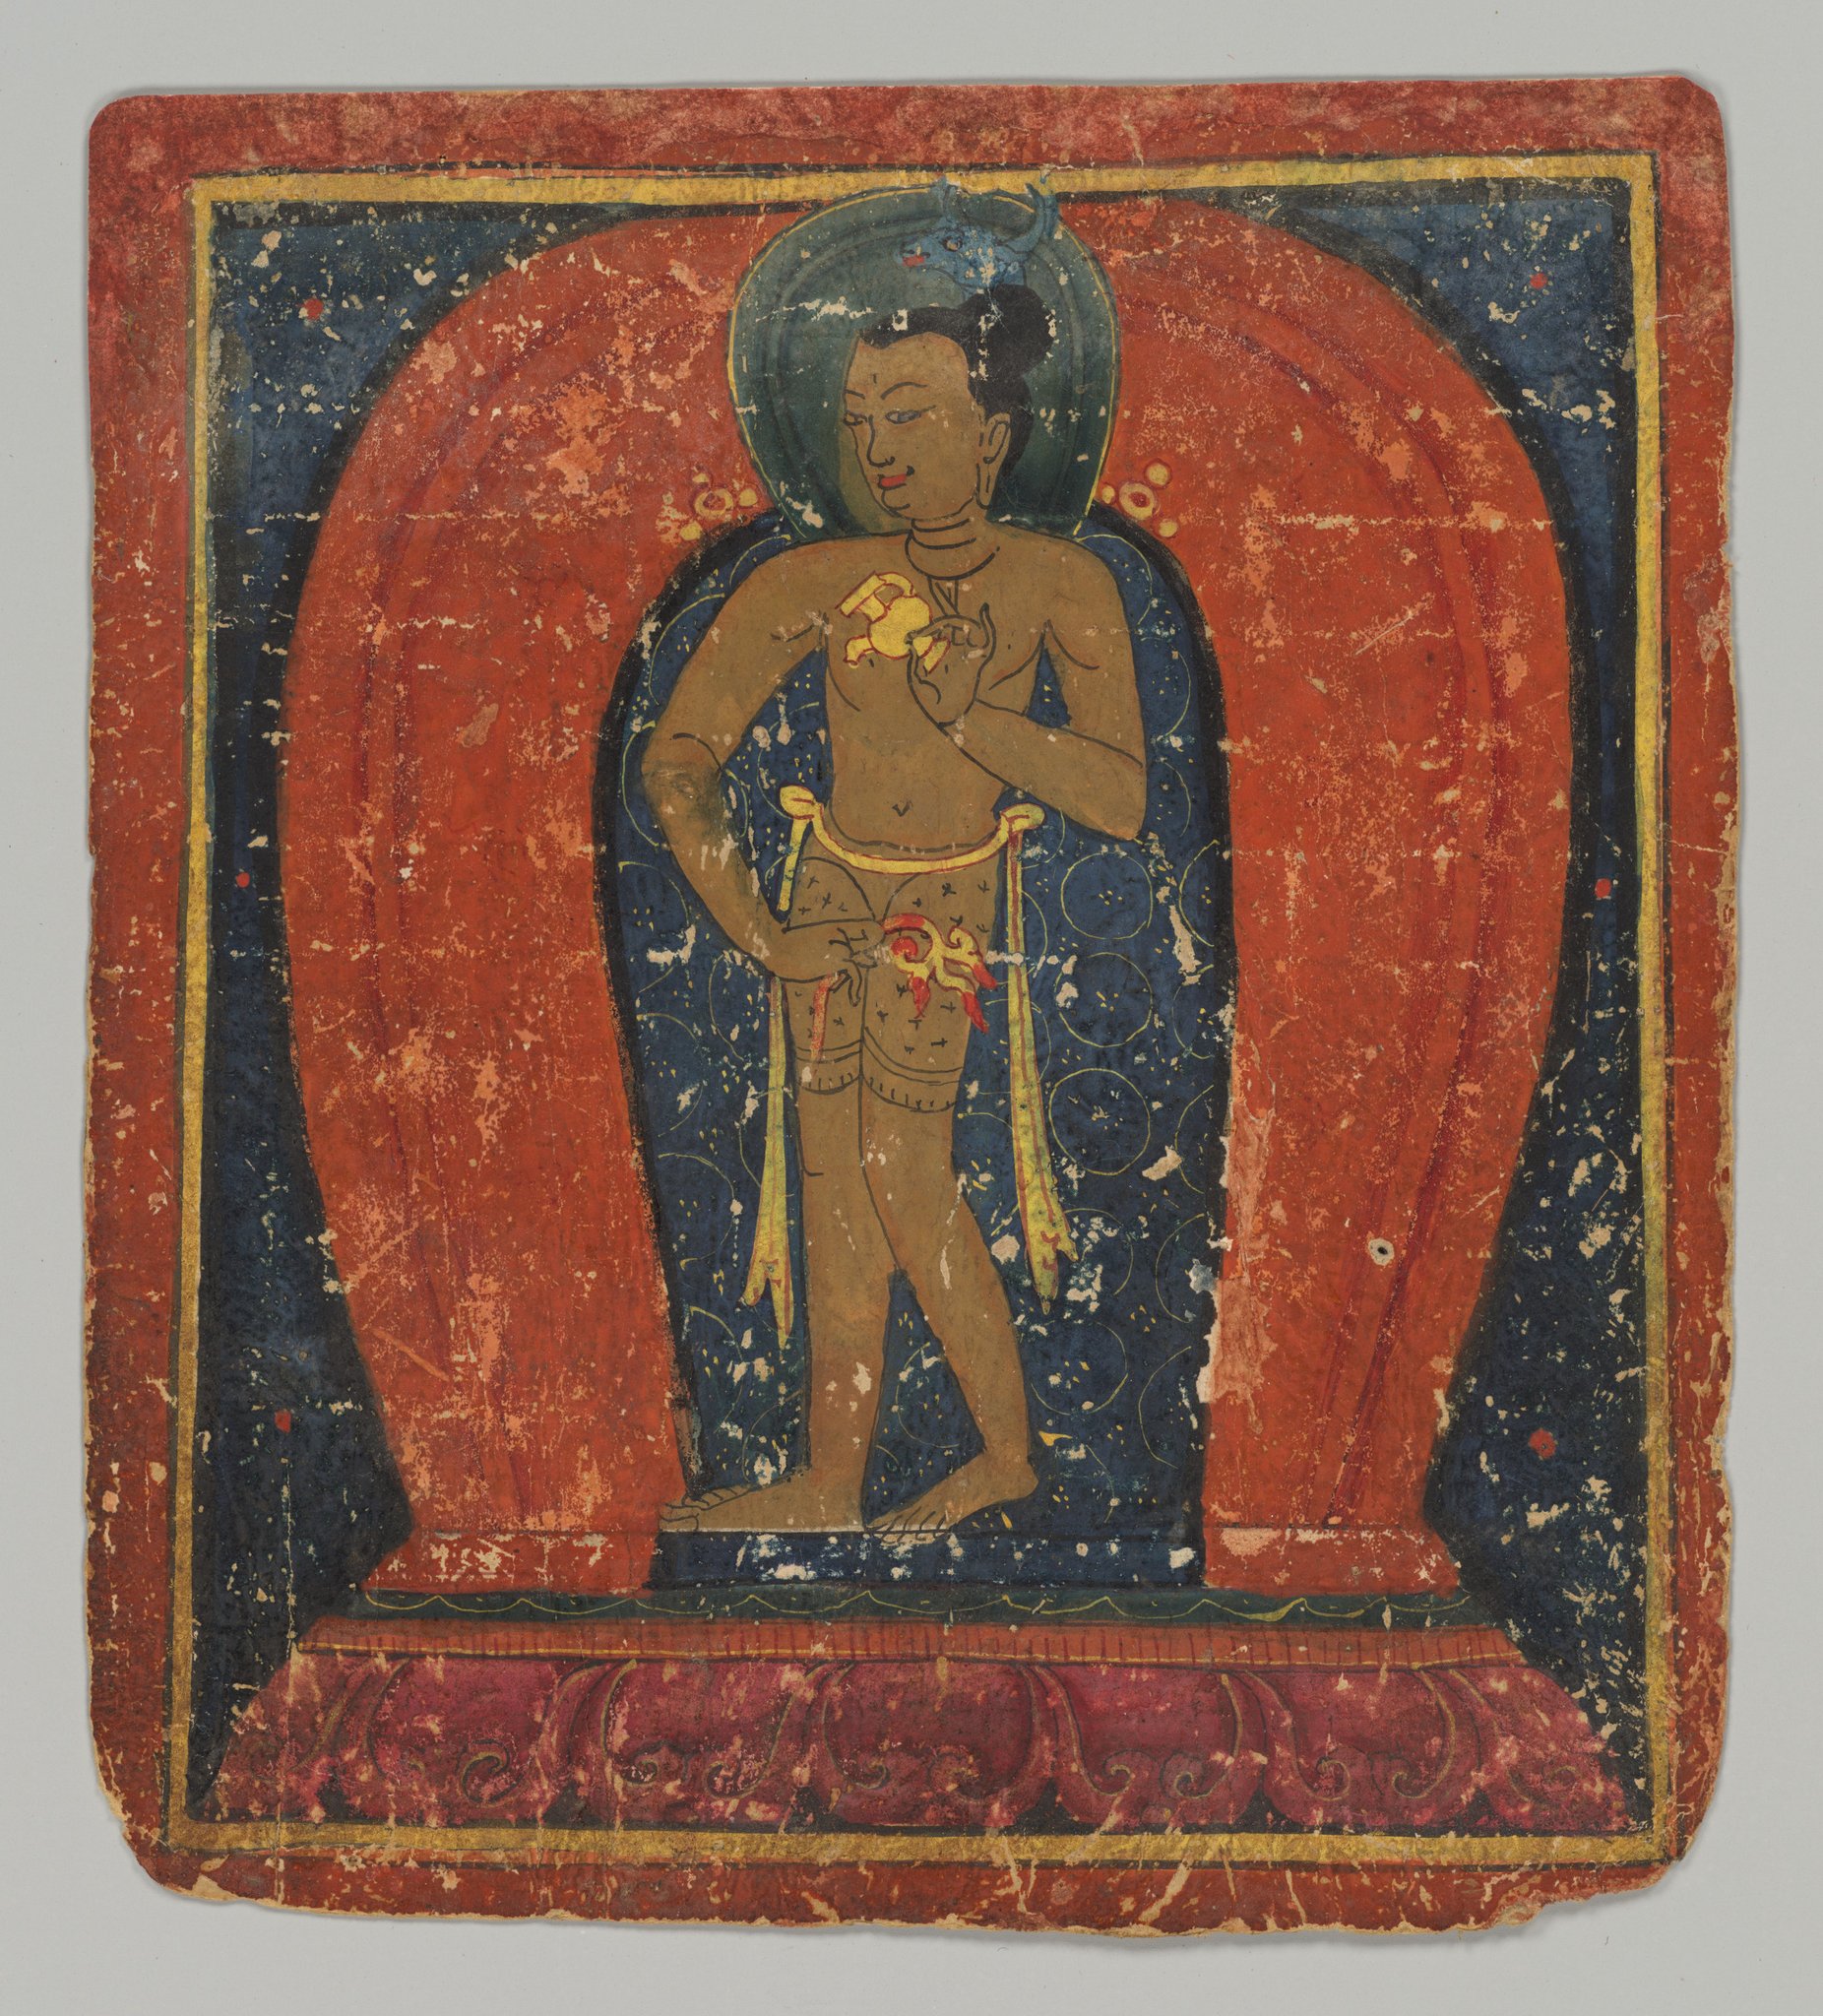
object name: initiation card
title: Initiation Card (Tsakalis)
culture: tibetan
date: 1401-1433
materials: paper, watercolor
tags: buddhism,deities